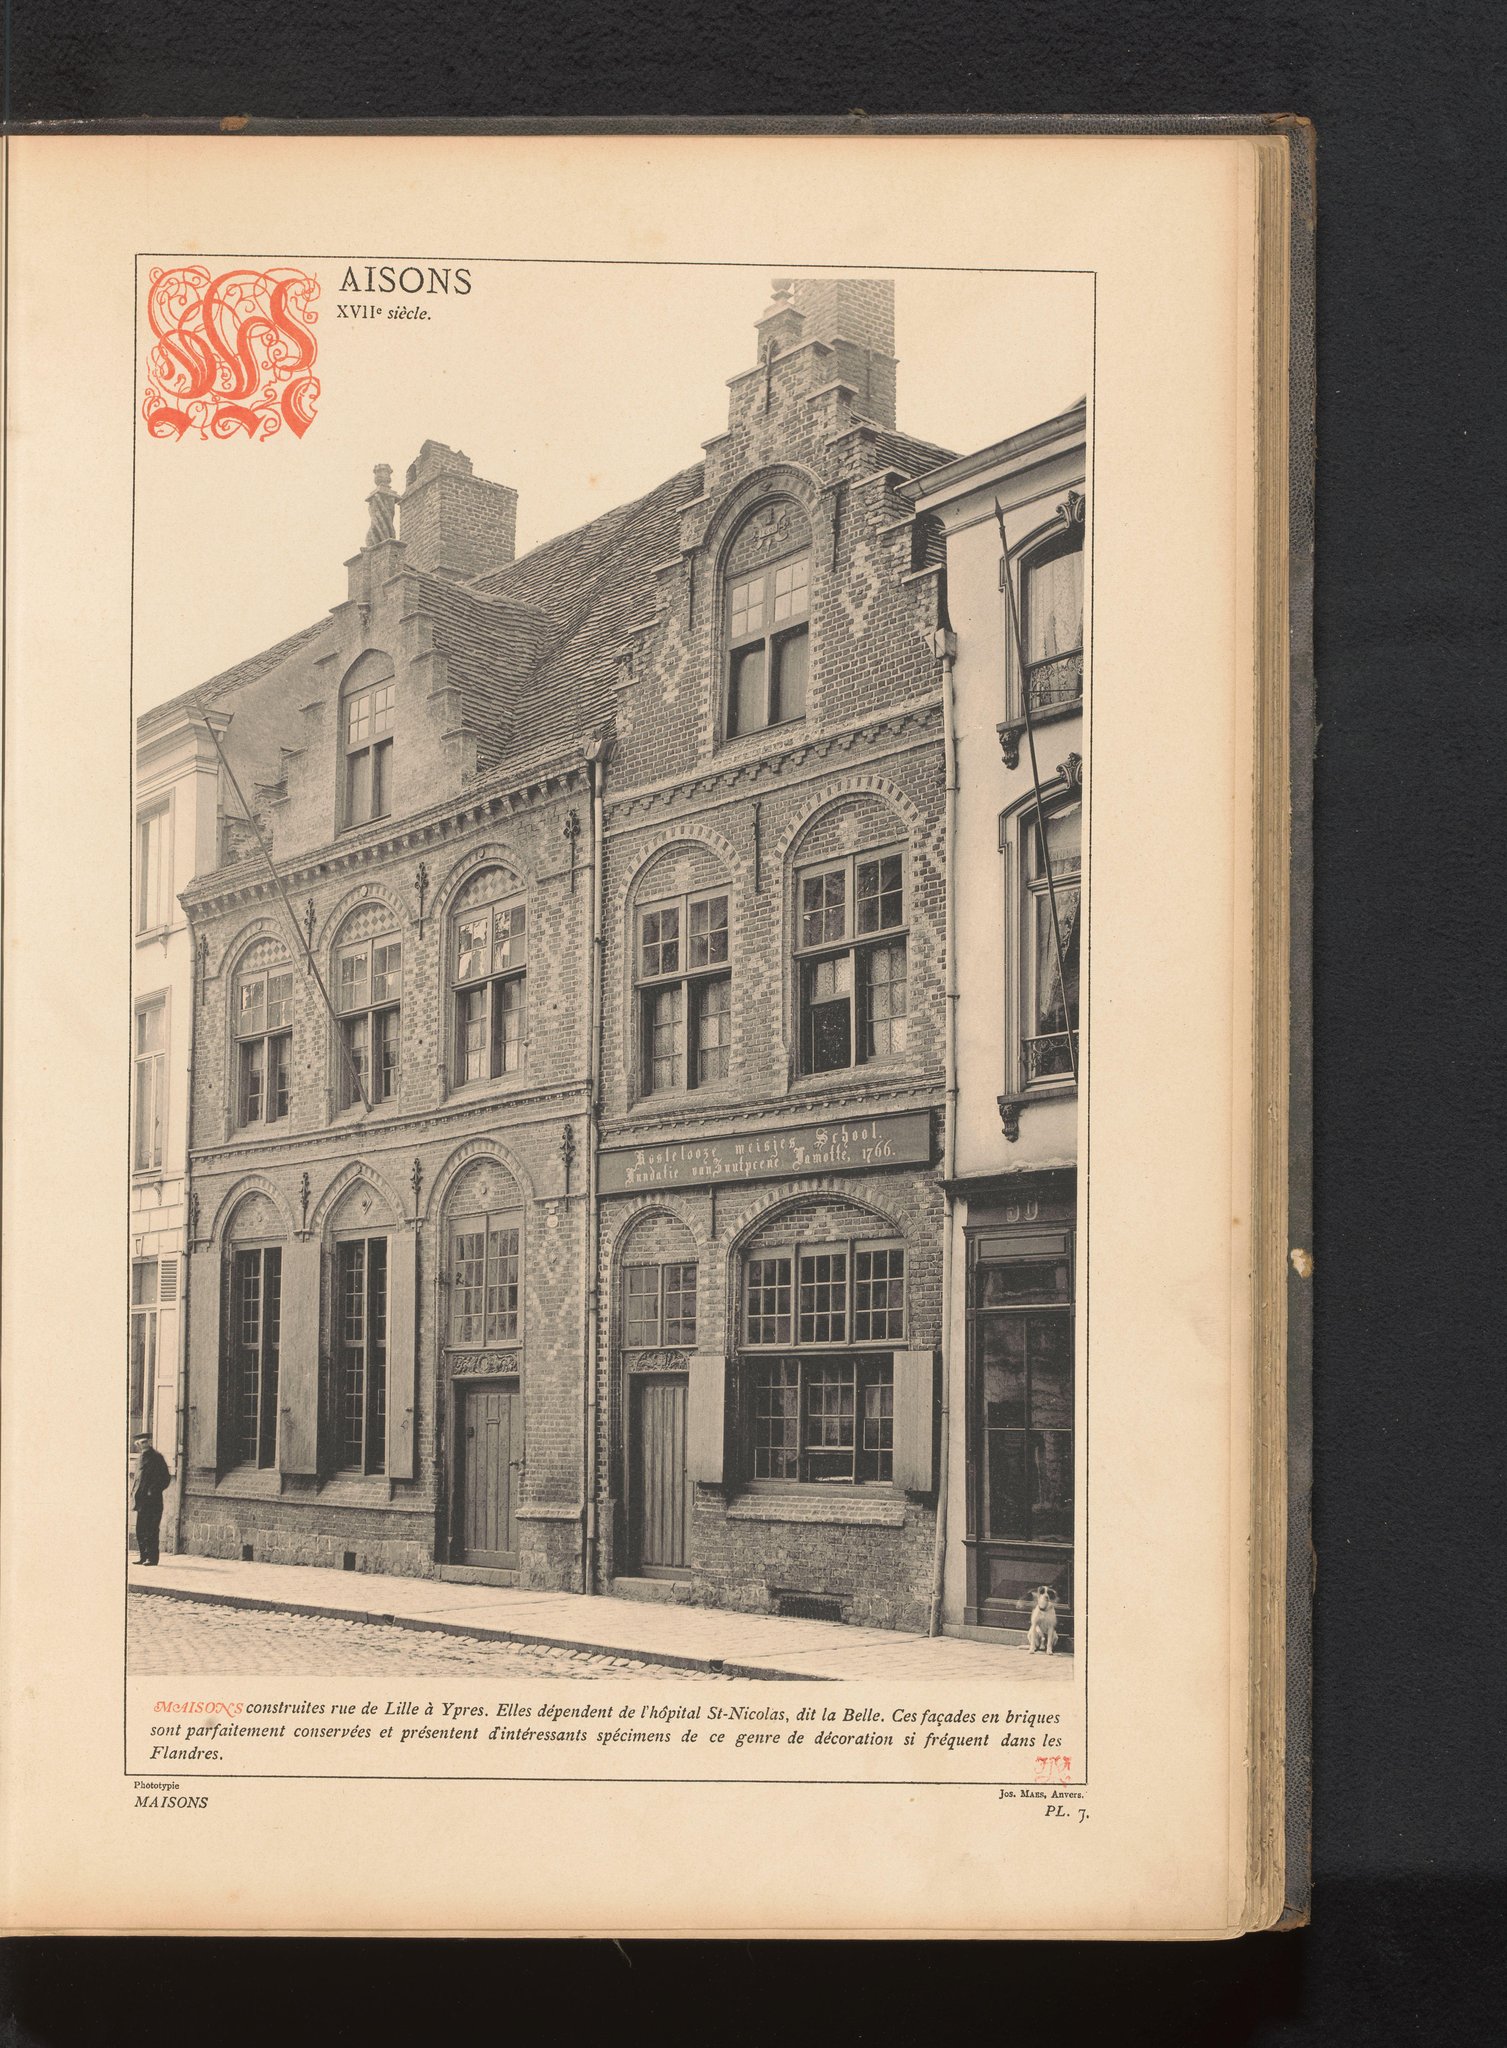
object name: photomechanical print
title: Woningen aan de Rue de Lille te Ieper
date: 1881-1889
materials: paper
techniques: photograph, photolithography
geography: antwerp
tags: decorated gable, civic architecture; edifices; dwellings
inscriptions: inscription: ‘MAISONS. PL. 7.’, monogram: ‘JJvY’, inscription: ‘MAISONS construites rue (...)’